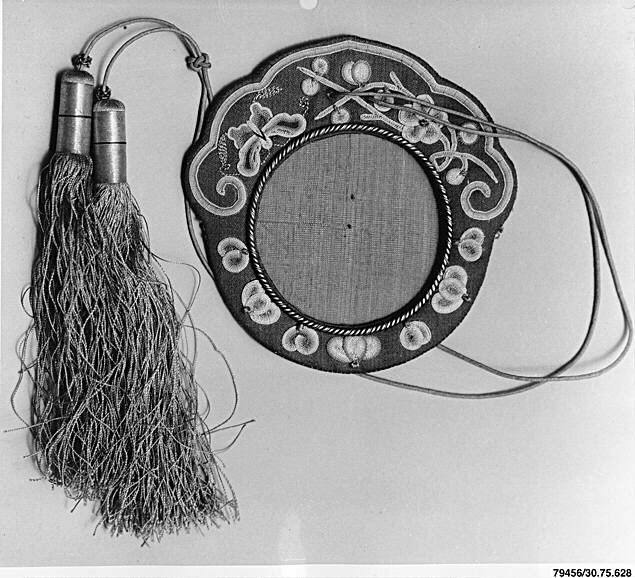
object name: mirror case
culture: chinese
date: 1701-1900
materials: silk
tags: butterflies